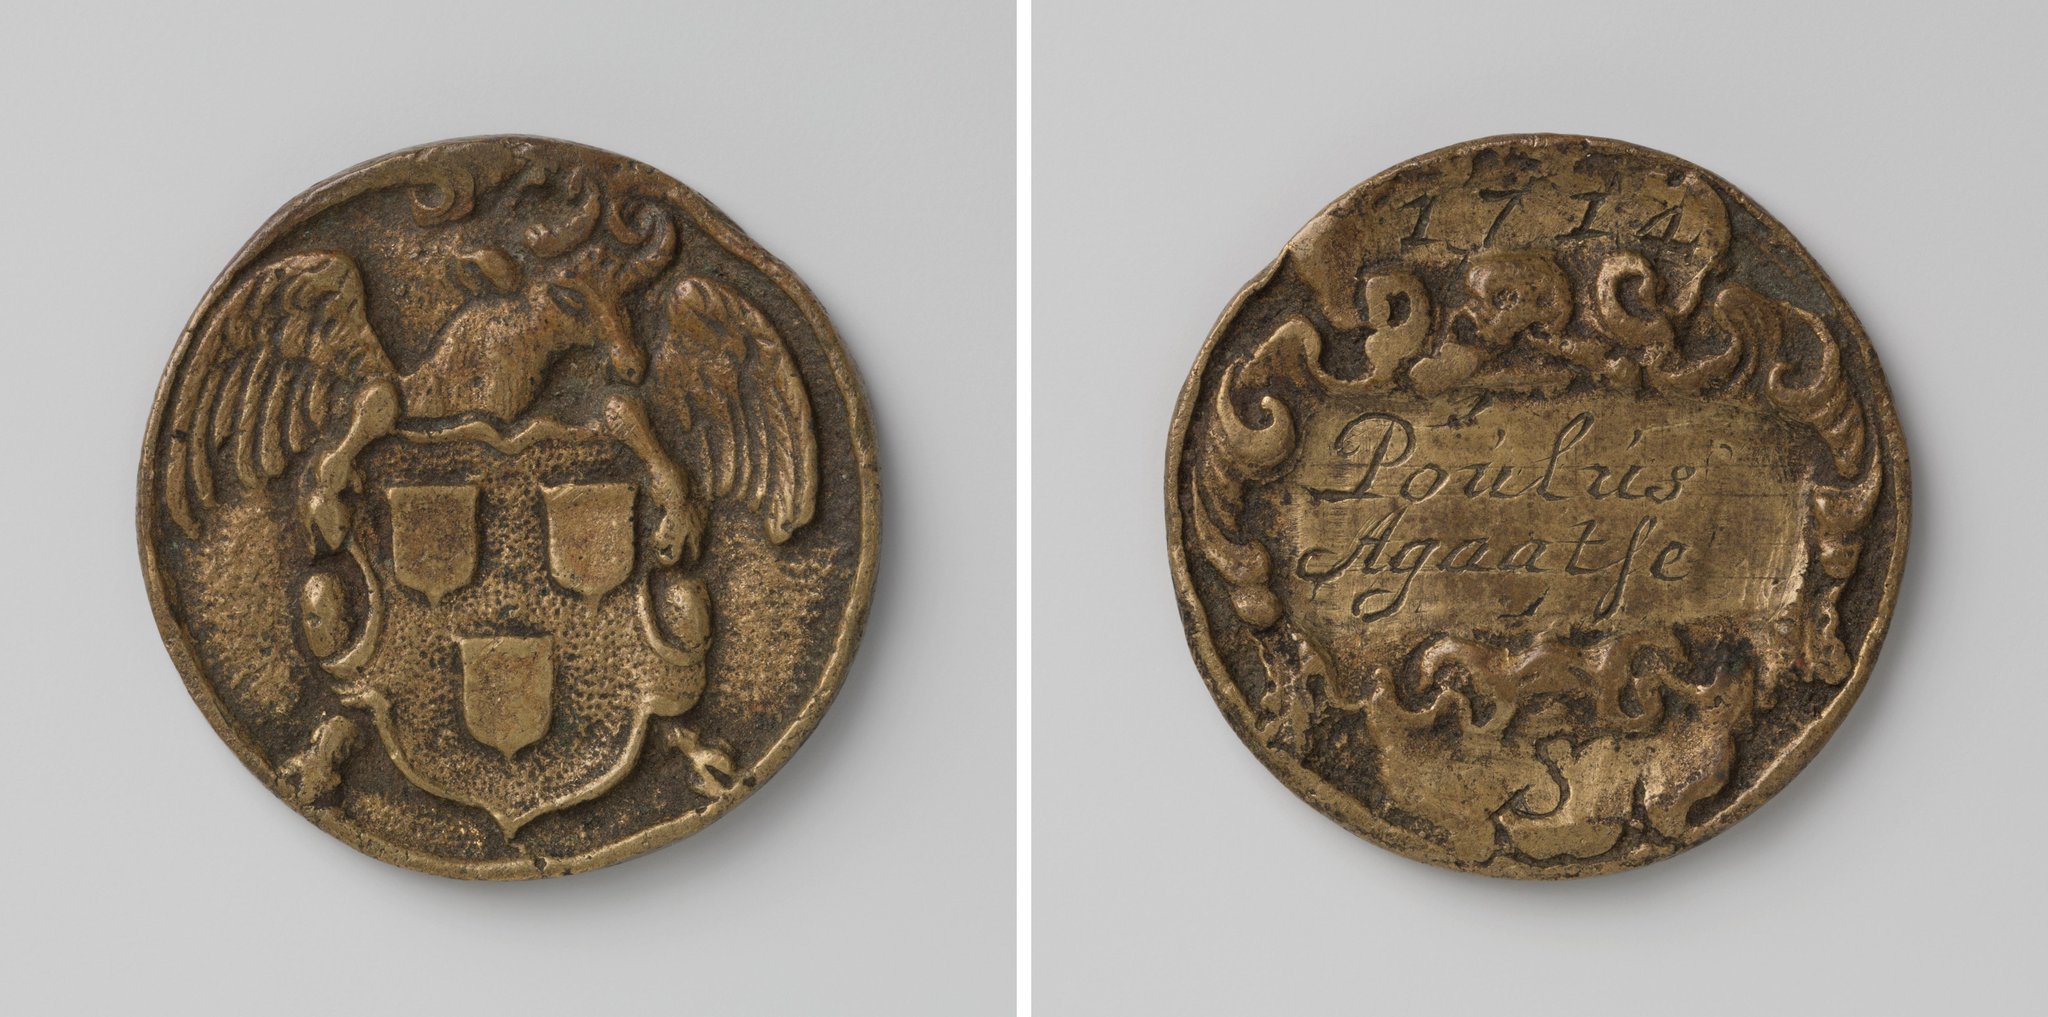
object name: medal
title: St. Lucasgilde van Amsterdam, gildepenning van Poulus Agaatse, schilder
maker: Anonymous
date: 1714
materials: brass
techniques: casting, engraving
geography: amsterdam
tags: amsterdam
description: Messing penning. Voorzijde: gevleugelde os houdt Lucasschild in zijn poten. Keerzijde: cartouche met opschrift onder doodshoofd en beenderen, en cartouche met jaartal, boven cartouche met letter S